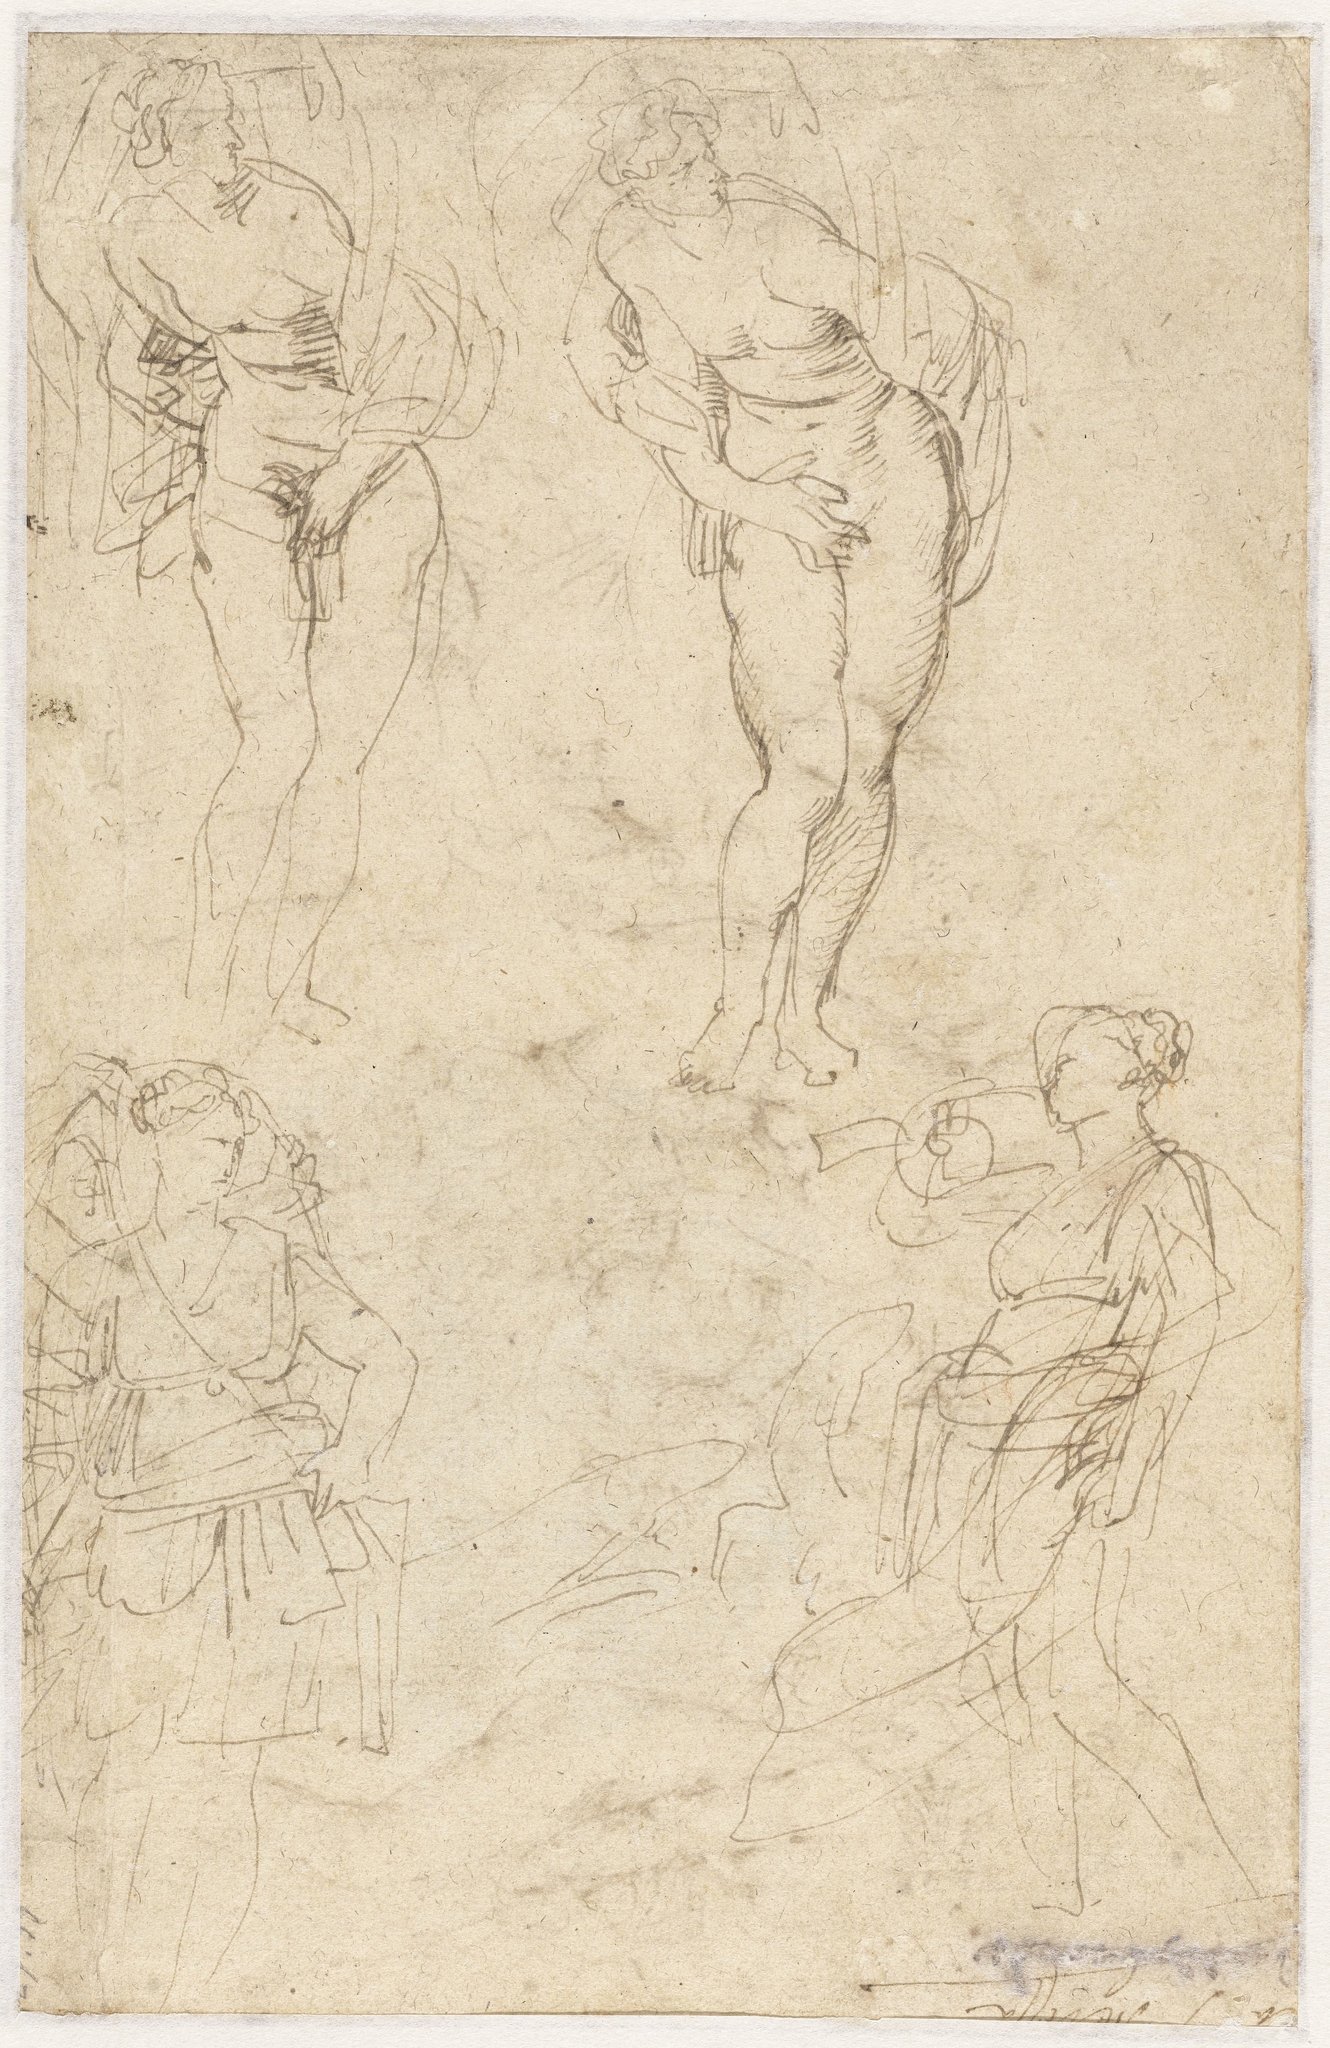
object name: drawing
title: Schetsen van de dochters van Cecrops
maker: peter paul rubens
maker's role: draughtsman, painter, print maker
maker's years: 1577-1640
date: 1611-1616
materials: ink, paper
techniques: pen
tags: (story of) cecrops' daughters (cecropides)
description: Schetsen van staande vrouwen: de dochters van Cecrops.